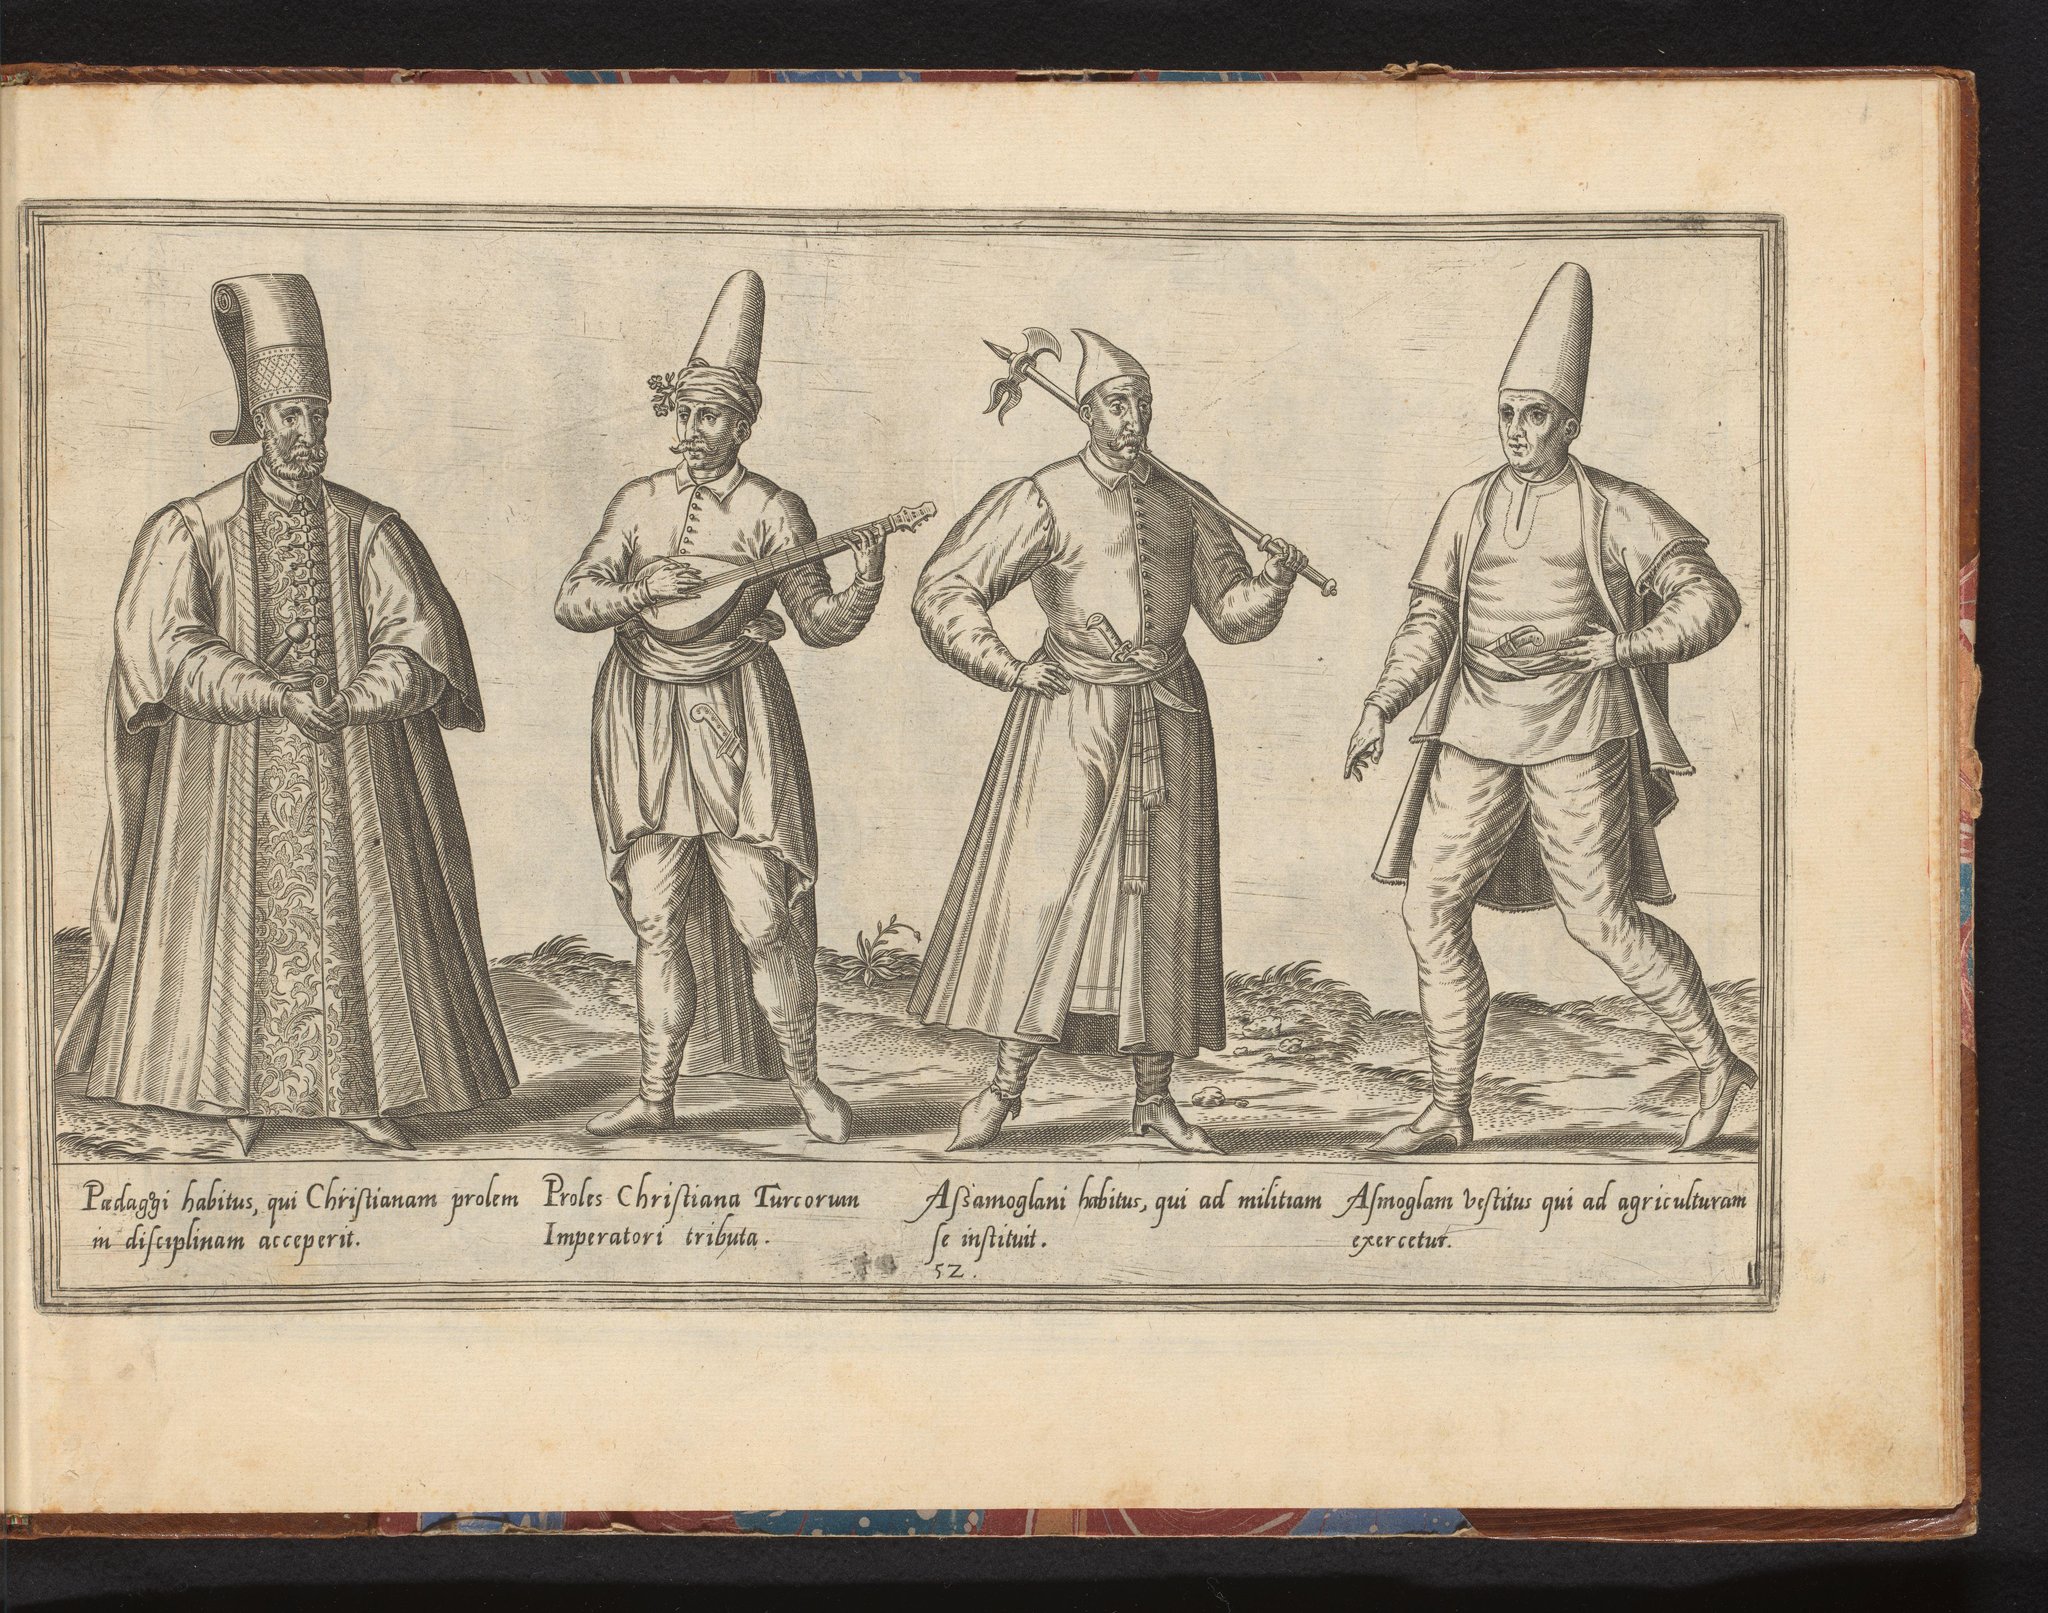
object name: album leaf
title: Vier Turken, gekleed volgens de mode van ca. 1580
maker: abraham de bruyn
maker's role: print maker, publisher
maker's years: 1540-1587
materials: paper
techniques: engraving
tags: asiatic races and peoples: turks (+ costume)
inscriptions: number: ‘52’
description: Prent uit het boek 'Omnium pene Europae, Asiae, Aphricae atque Americae gentium habitus...', 1581. De prent maakt deel uit van een album.